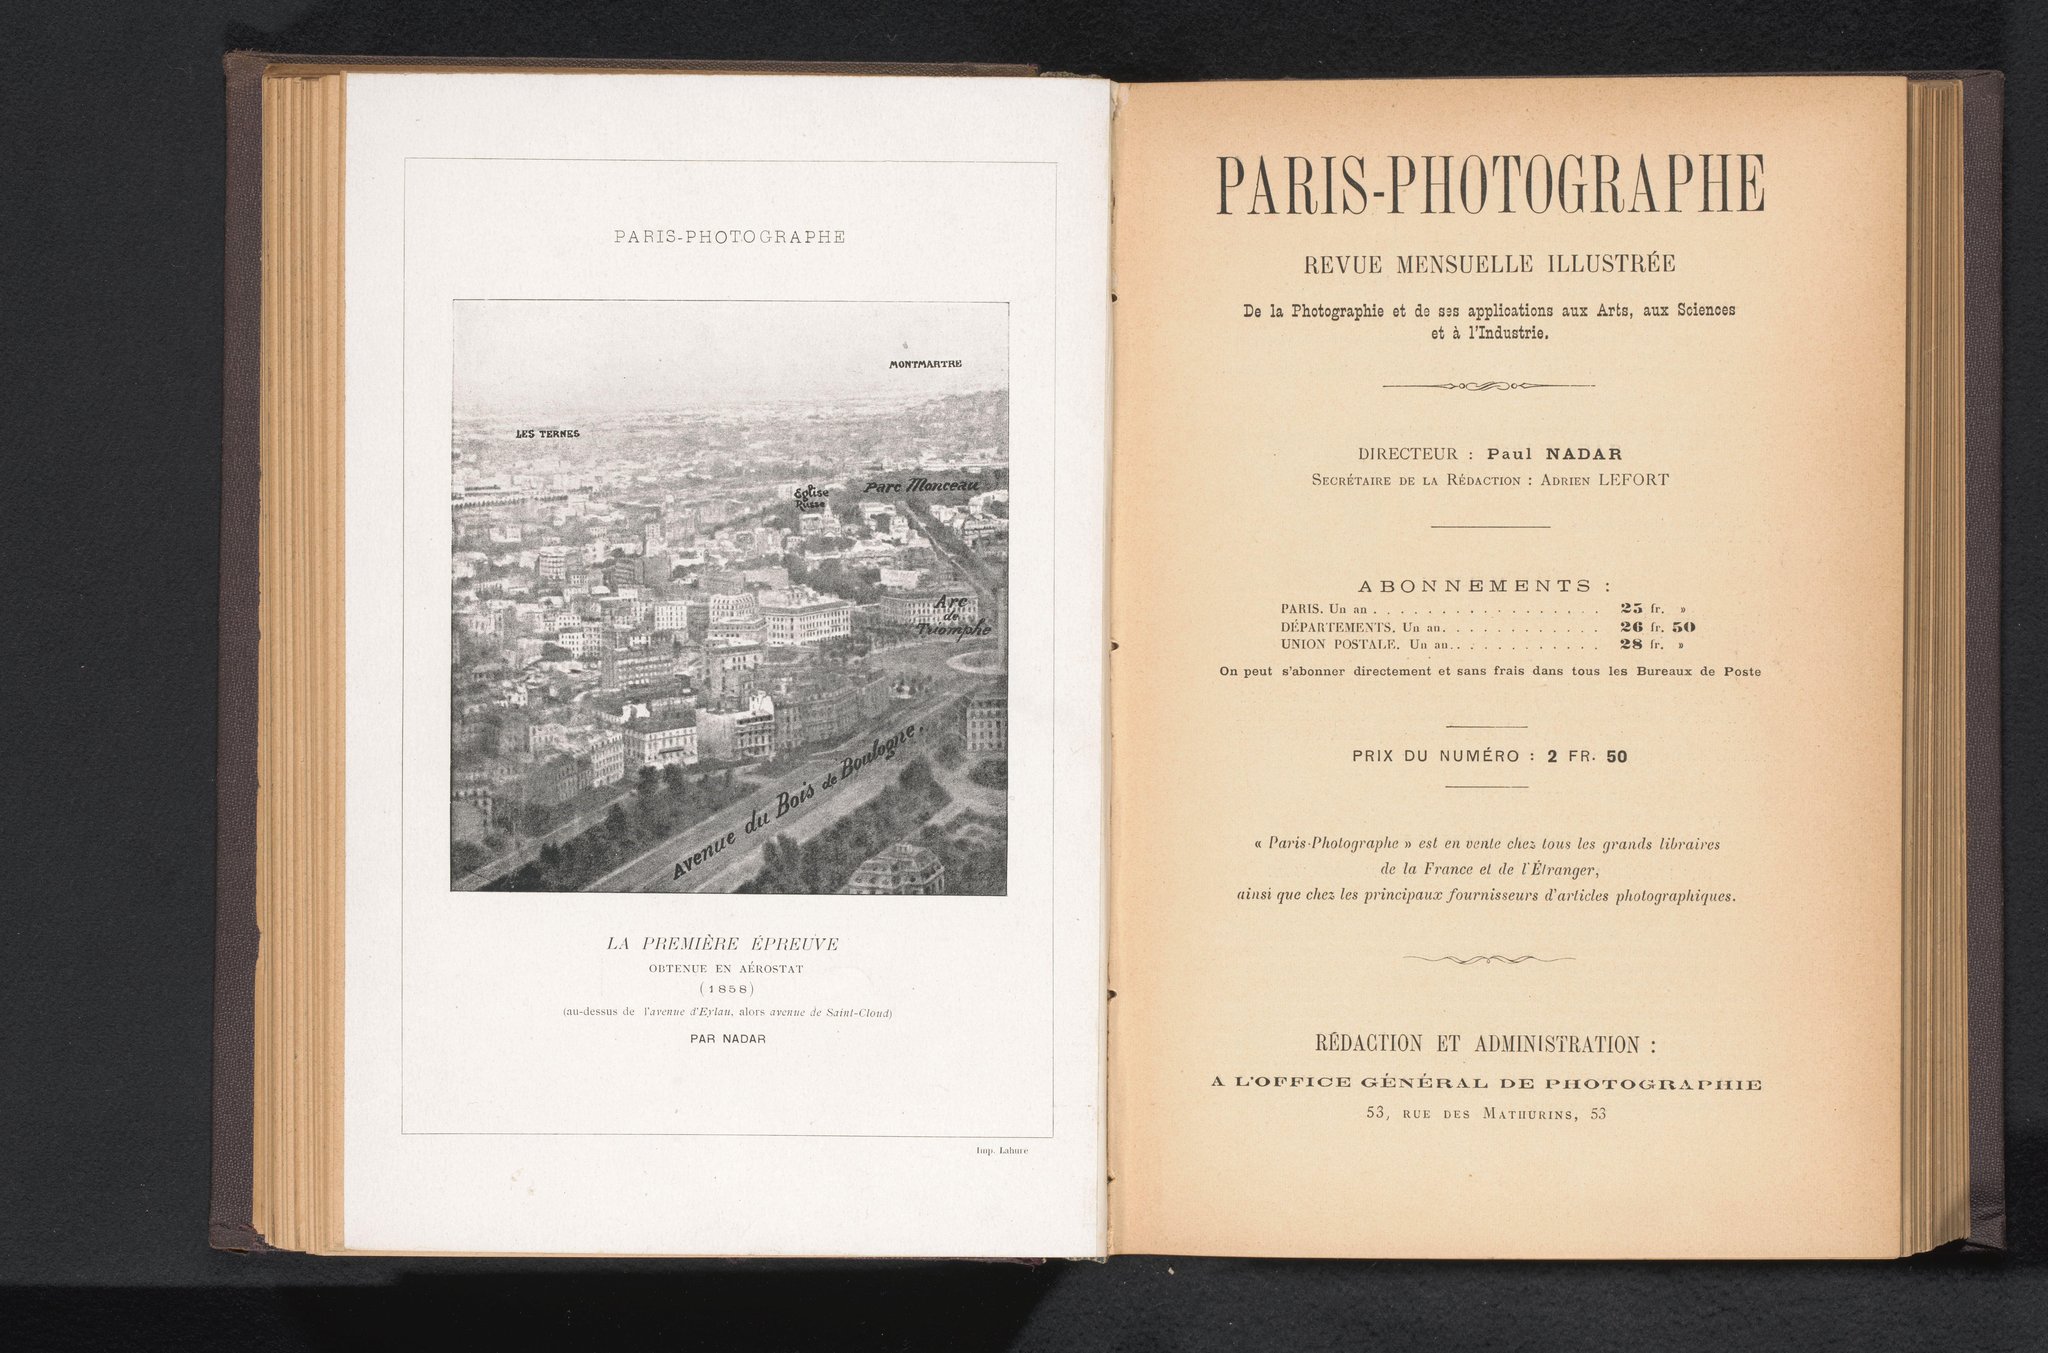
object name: page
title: Gezicht op Parijs met op de voorgrond de Avenue du Bois de Boulogne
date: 1858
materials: paper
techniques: autotype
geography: paris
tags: city-view, and landscape with man-made constructions, paris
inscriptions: inscription: ‘(au-dessus de l'avebbe d'Eylau, alors avenue de Saint-Cloud)’